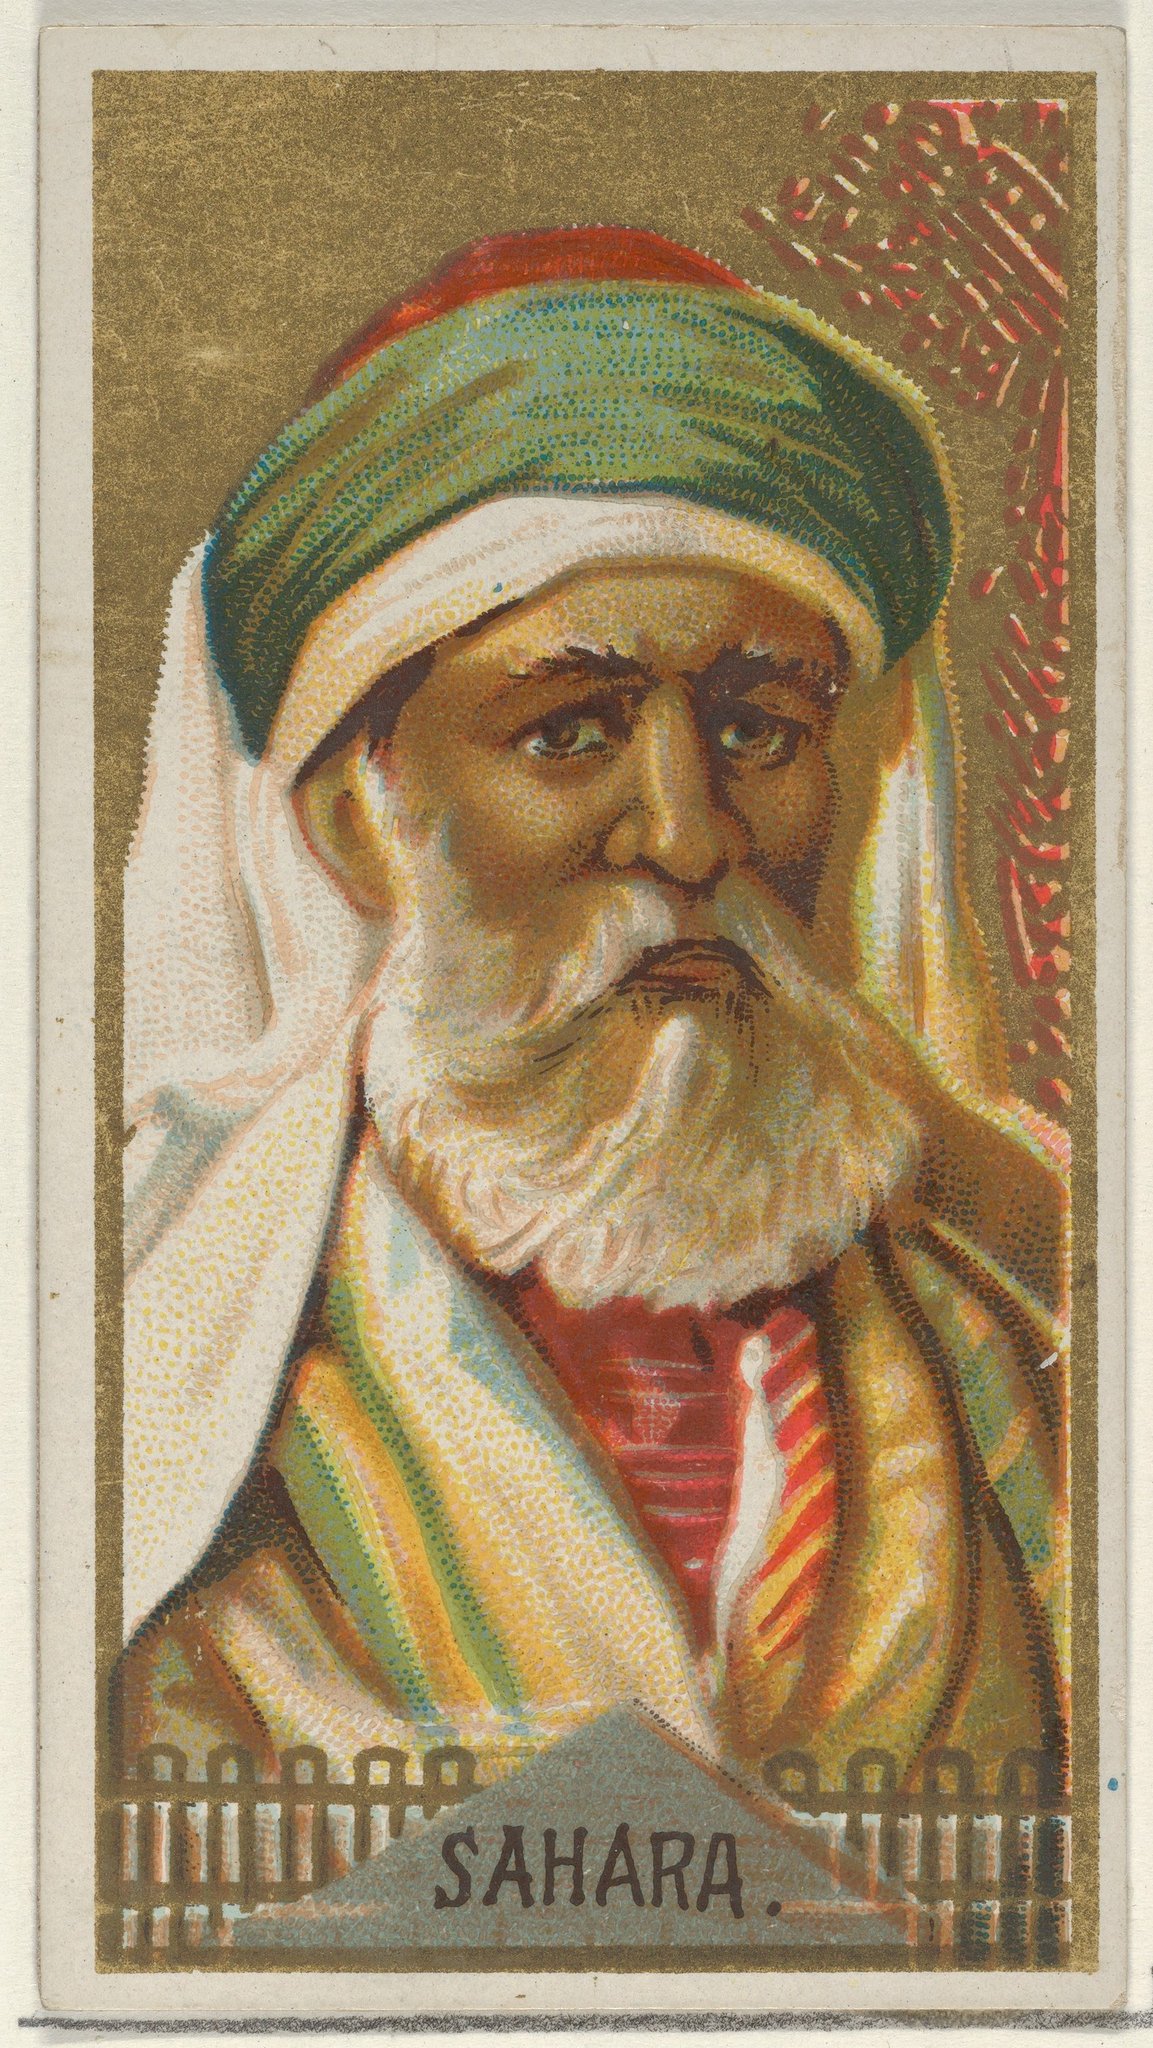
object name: print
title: Sahara, from the Types of All Nations series (N24) for Allen & Ginter Cigarettes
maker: allen & ginter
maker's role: publisher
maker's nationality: american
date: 1889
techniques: color lithograph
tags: men